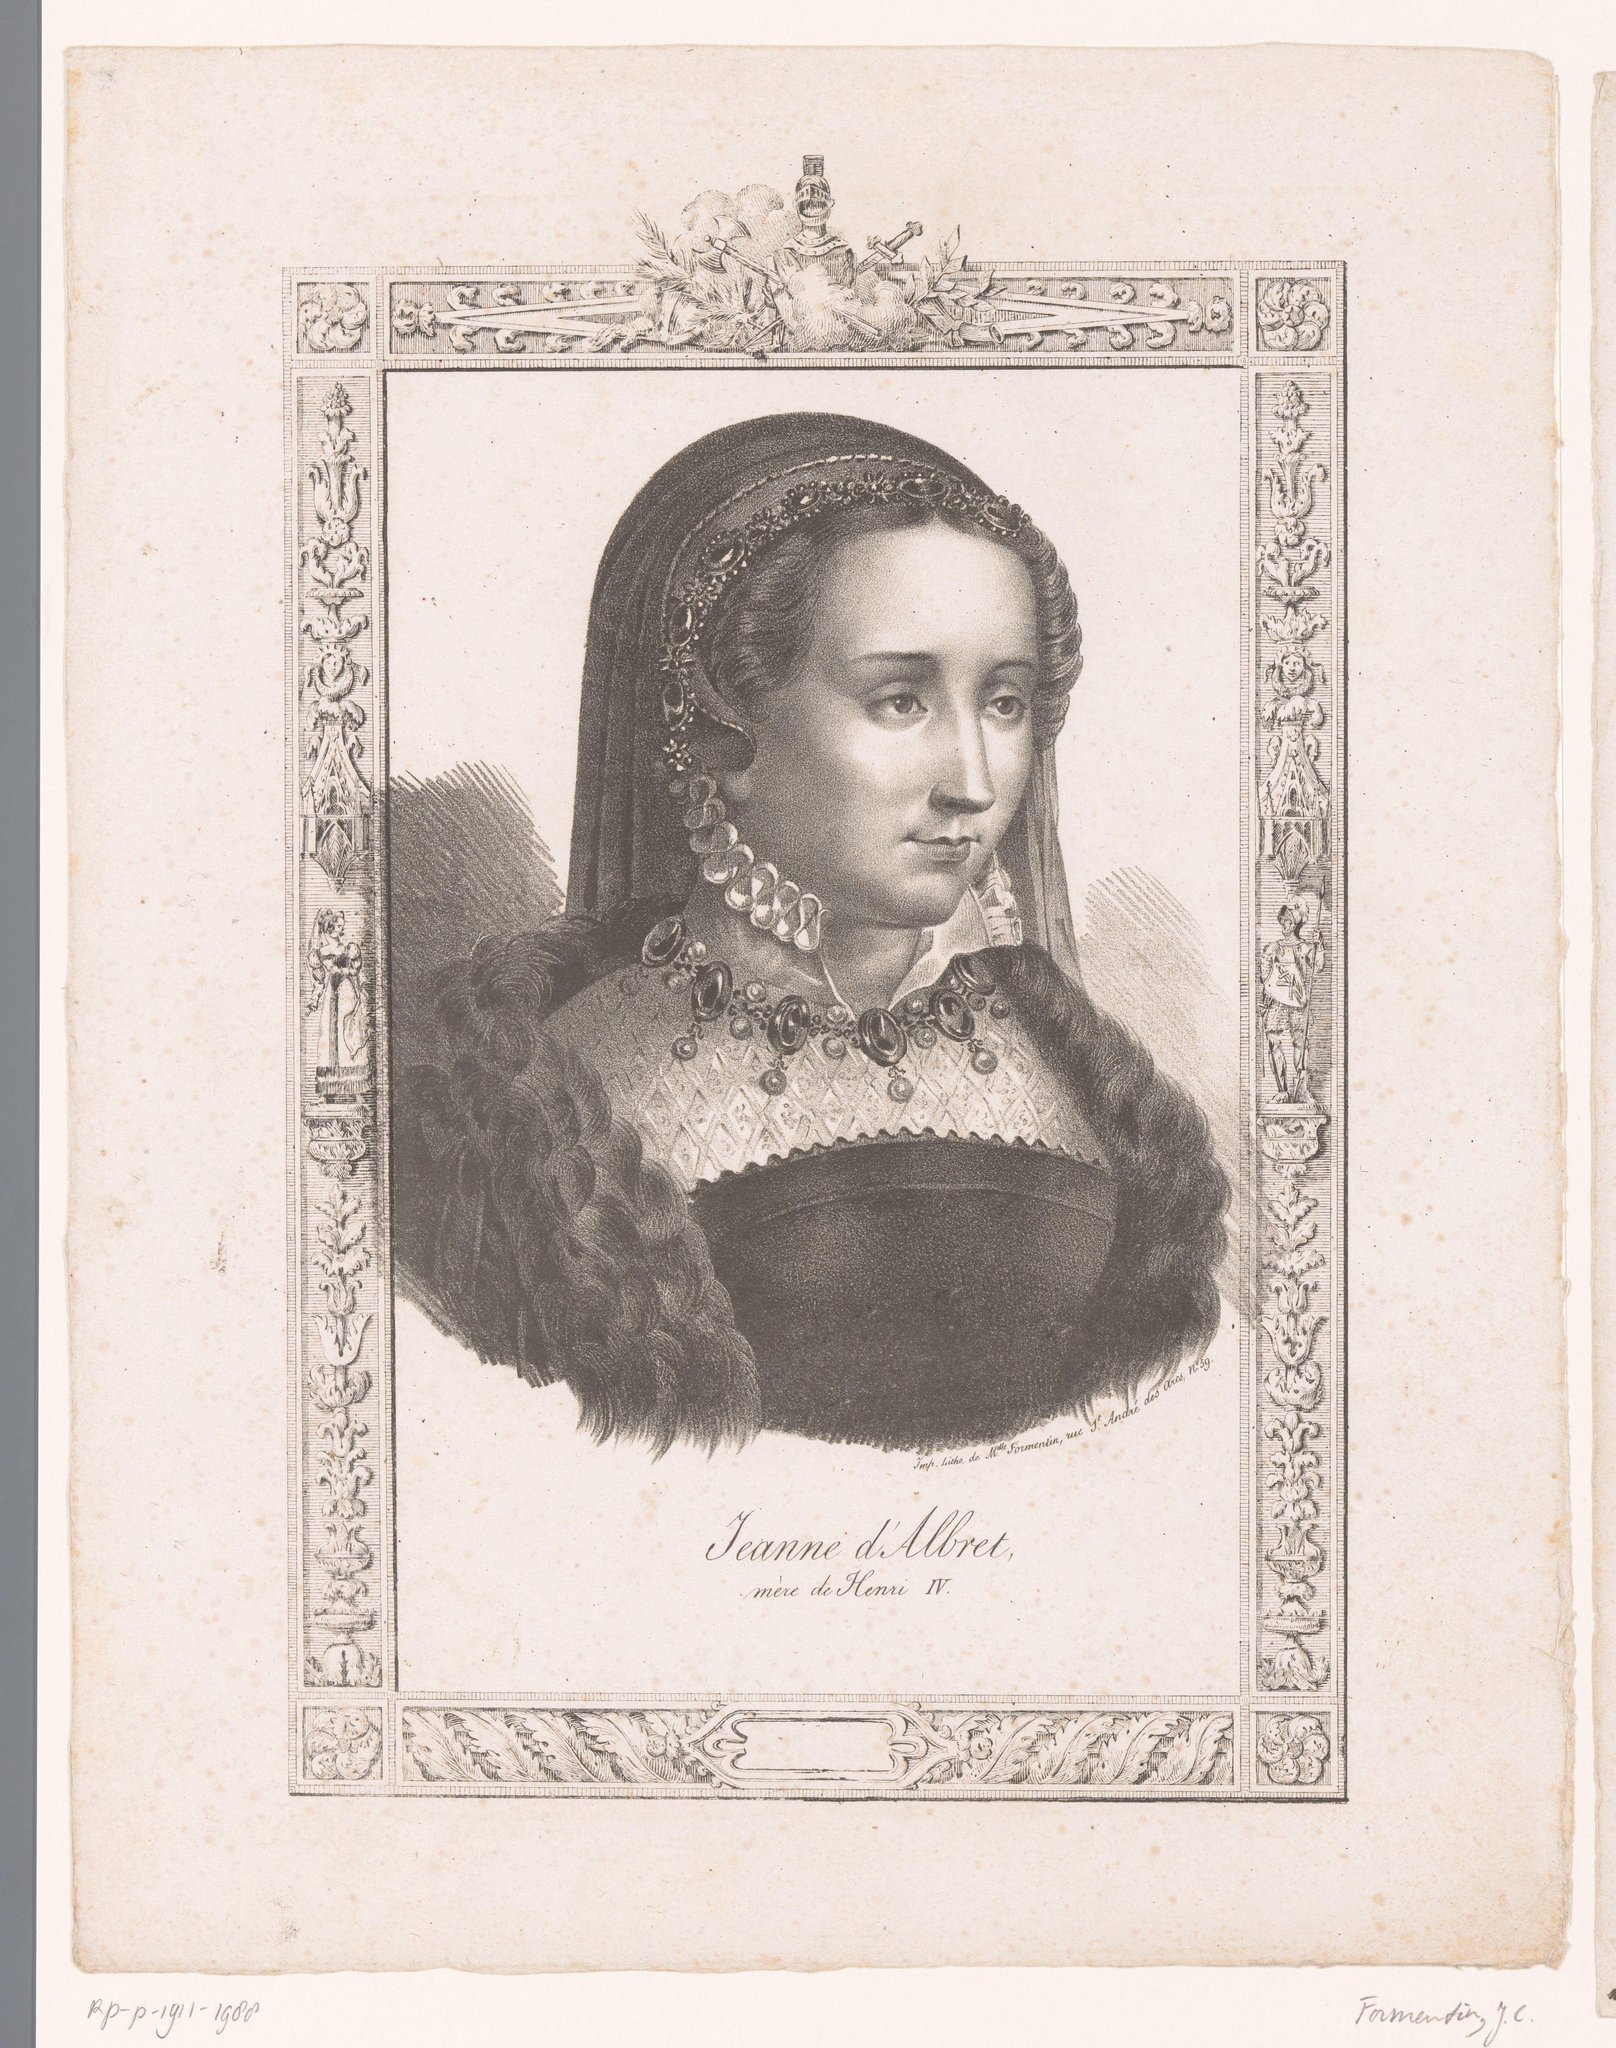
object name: print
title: Jeanne d'Albret, mère de Henri IV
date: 1824-1850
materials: paper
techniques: lithograph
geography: paris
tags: historical persons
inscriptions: collector's mark: Lugt 2228a